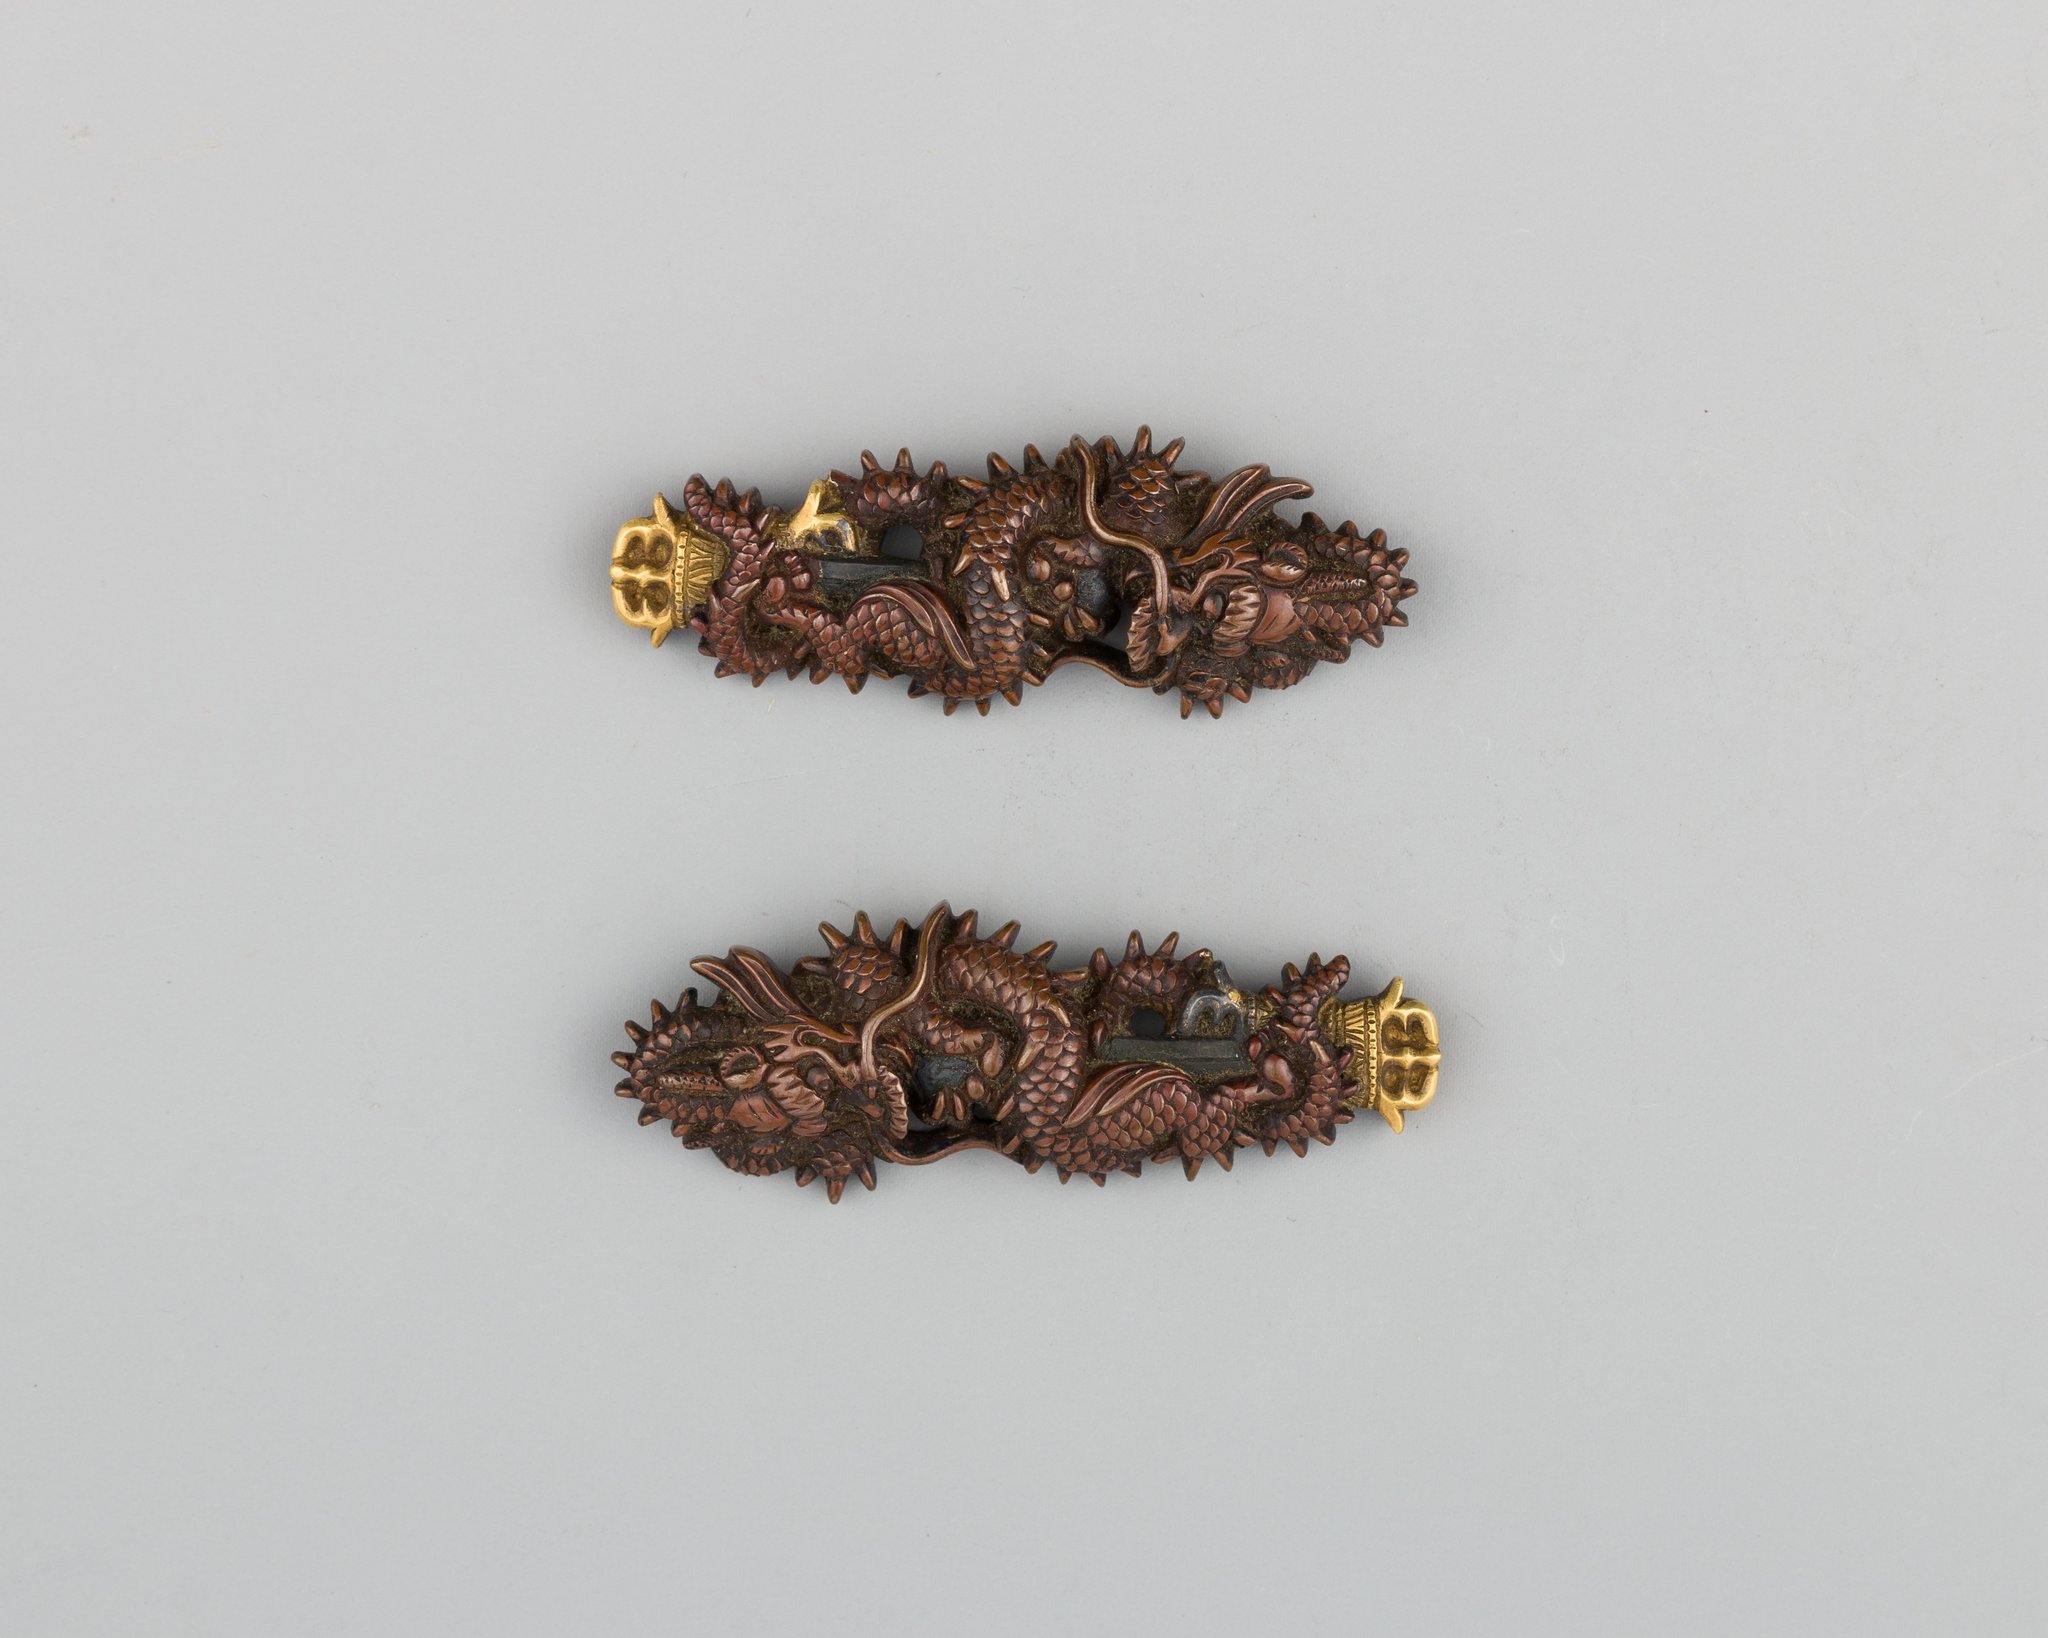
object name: pair of sword grip ornament menuki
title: Pair of Sword-Grip Ornaments (Menuki)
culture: japanese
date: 1701-1800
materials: copper, silver alloy, gold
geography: japan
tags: dragons